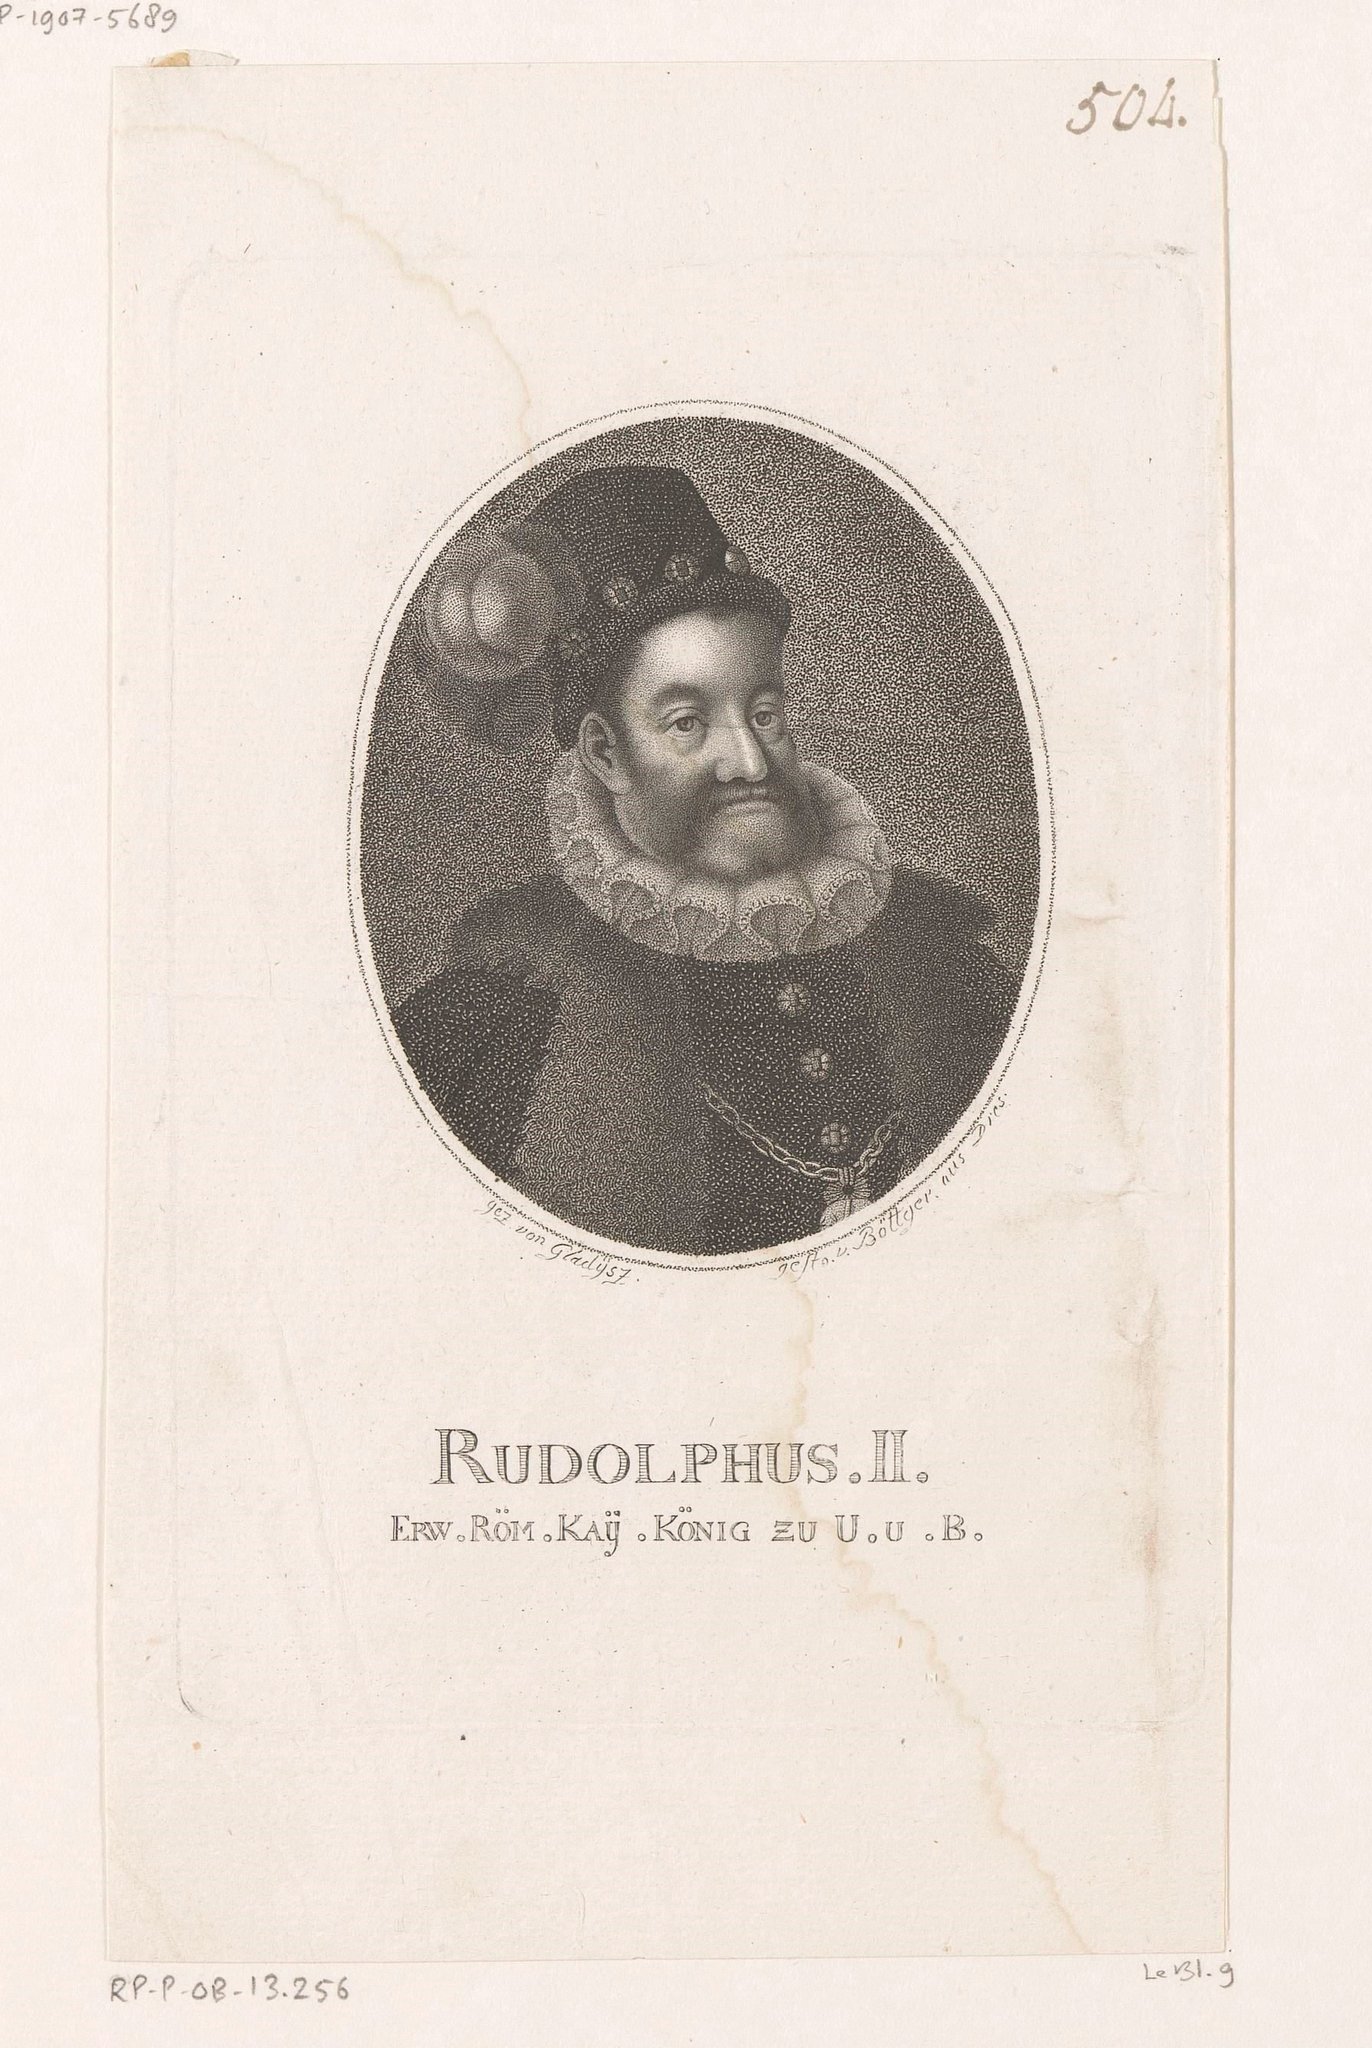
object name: print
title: Portret van Rudolf II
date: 1794-1825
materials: paper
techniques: stippling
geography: leipzig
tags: vienna, rudolf ii van habsburg (duits keizer), historical persons, knighthood order of the golden fleece - insignia of a knighthood order, e.g.: badge, chain (with name of order)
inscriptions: collector's mark: Lugt 2228